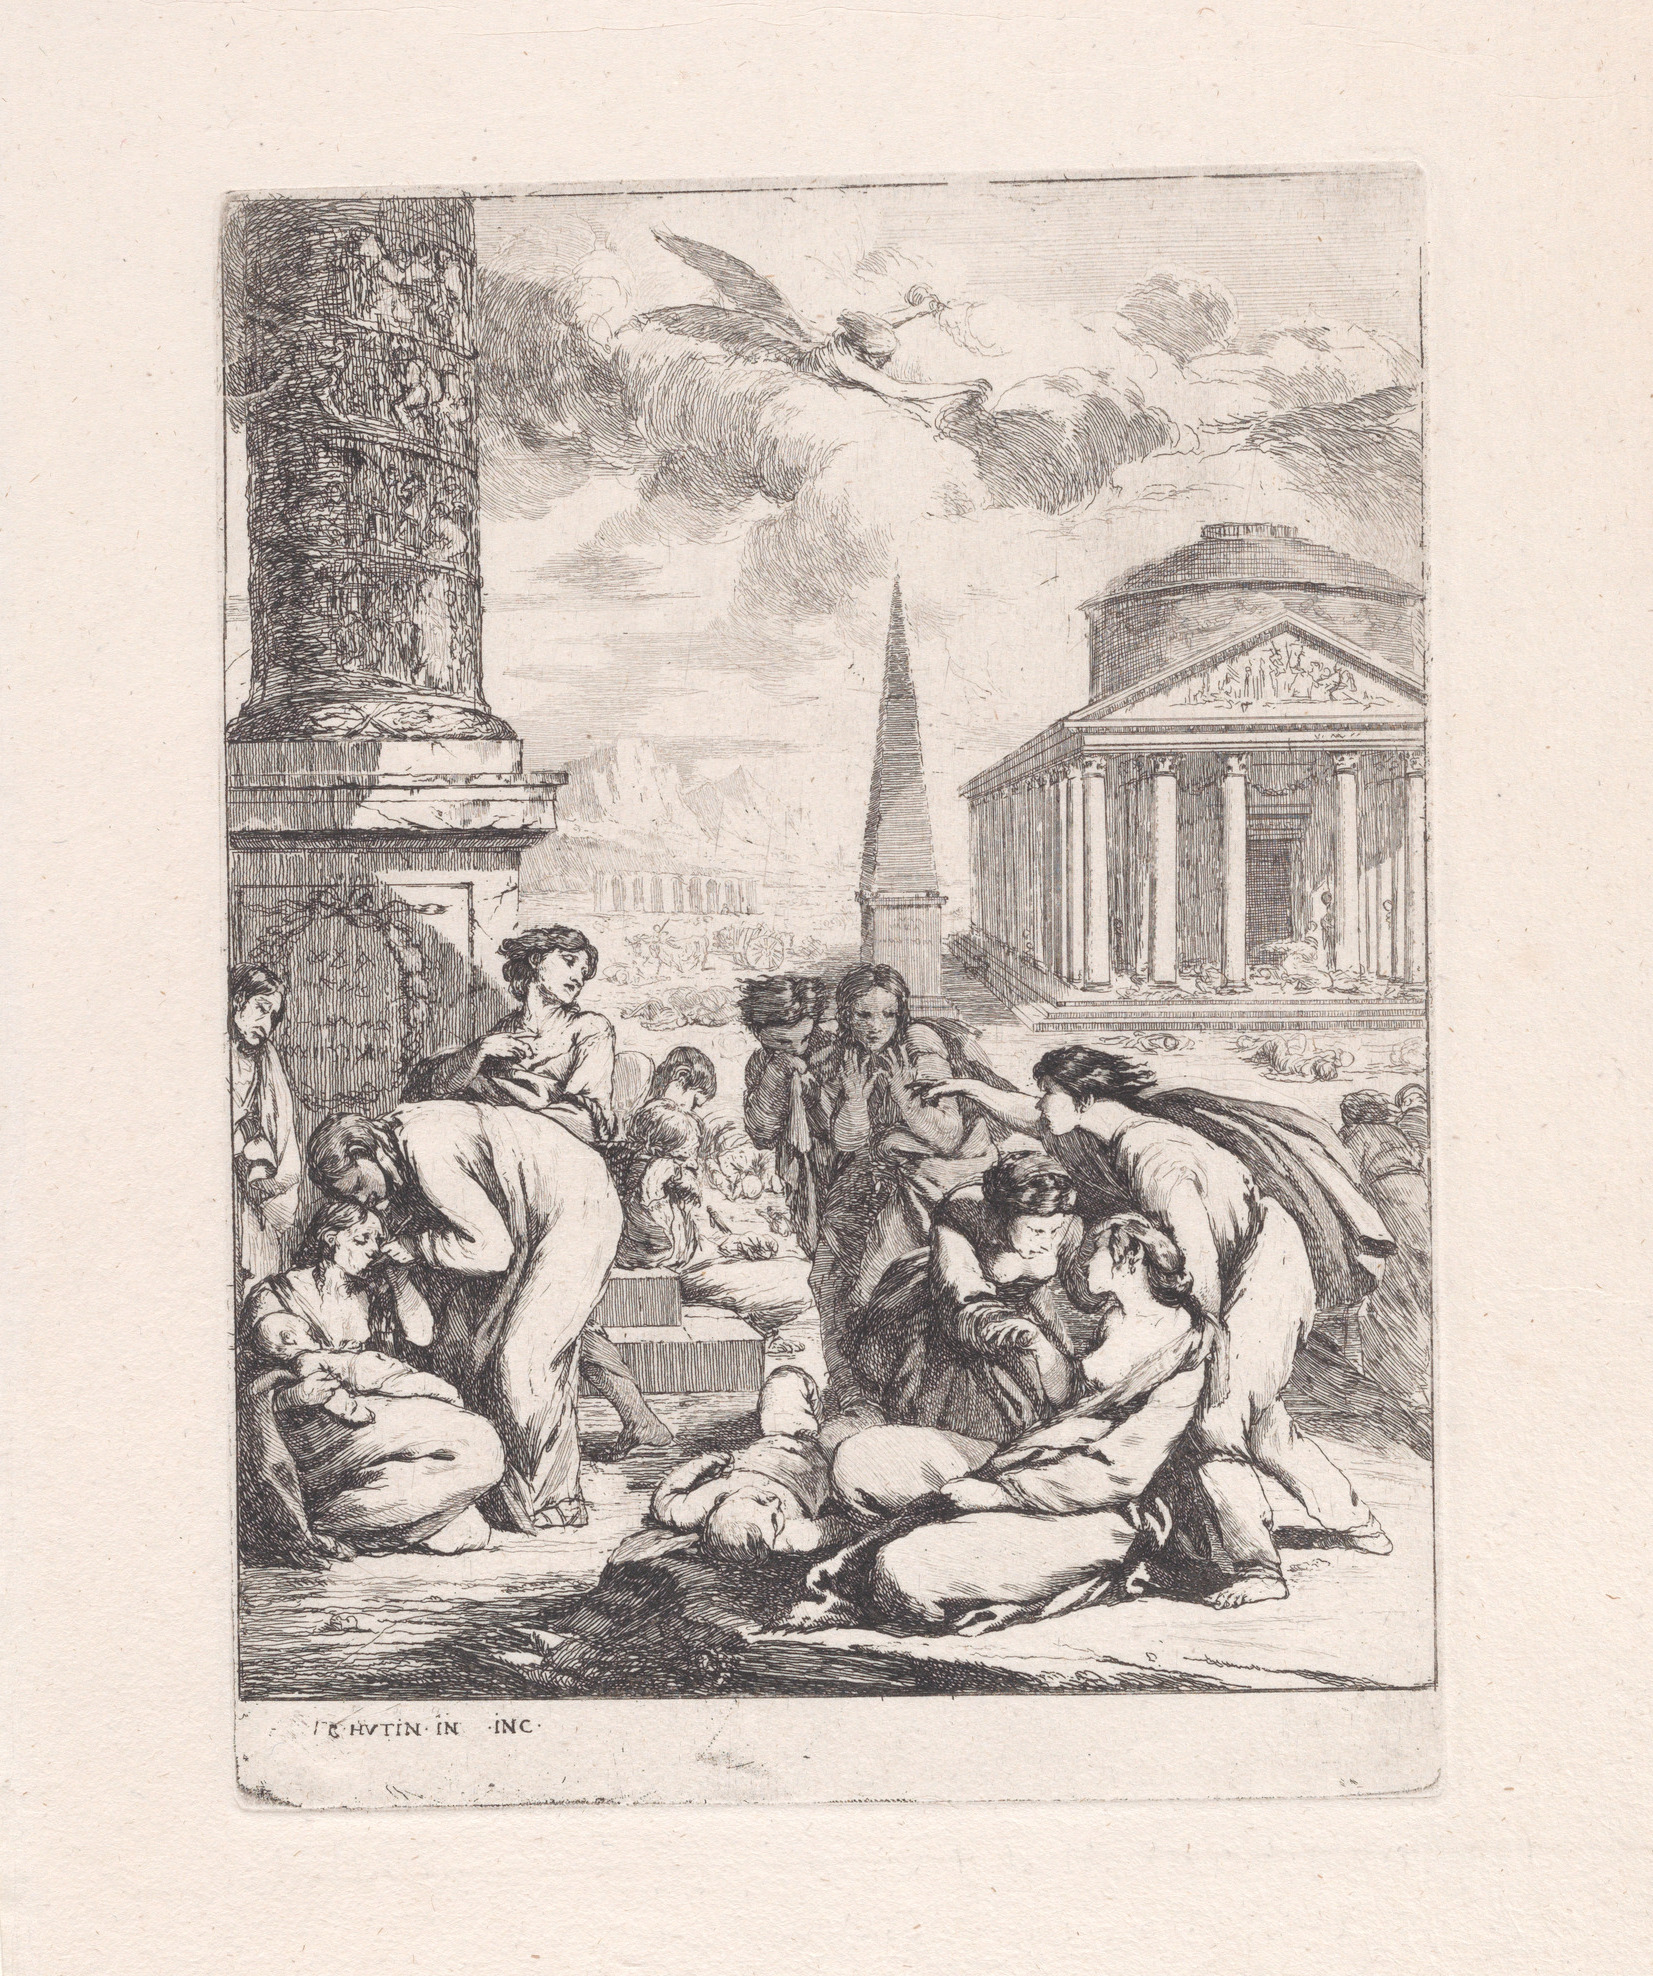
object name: print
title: Visiting the Sick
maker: françois hutin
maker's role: artist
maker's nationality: french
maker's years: 1686-1758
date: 1737-1742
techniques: etching